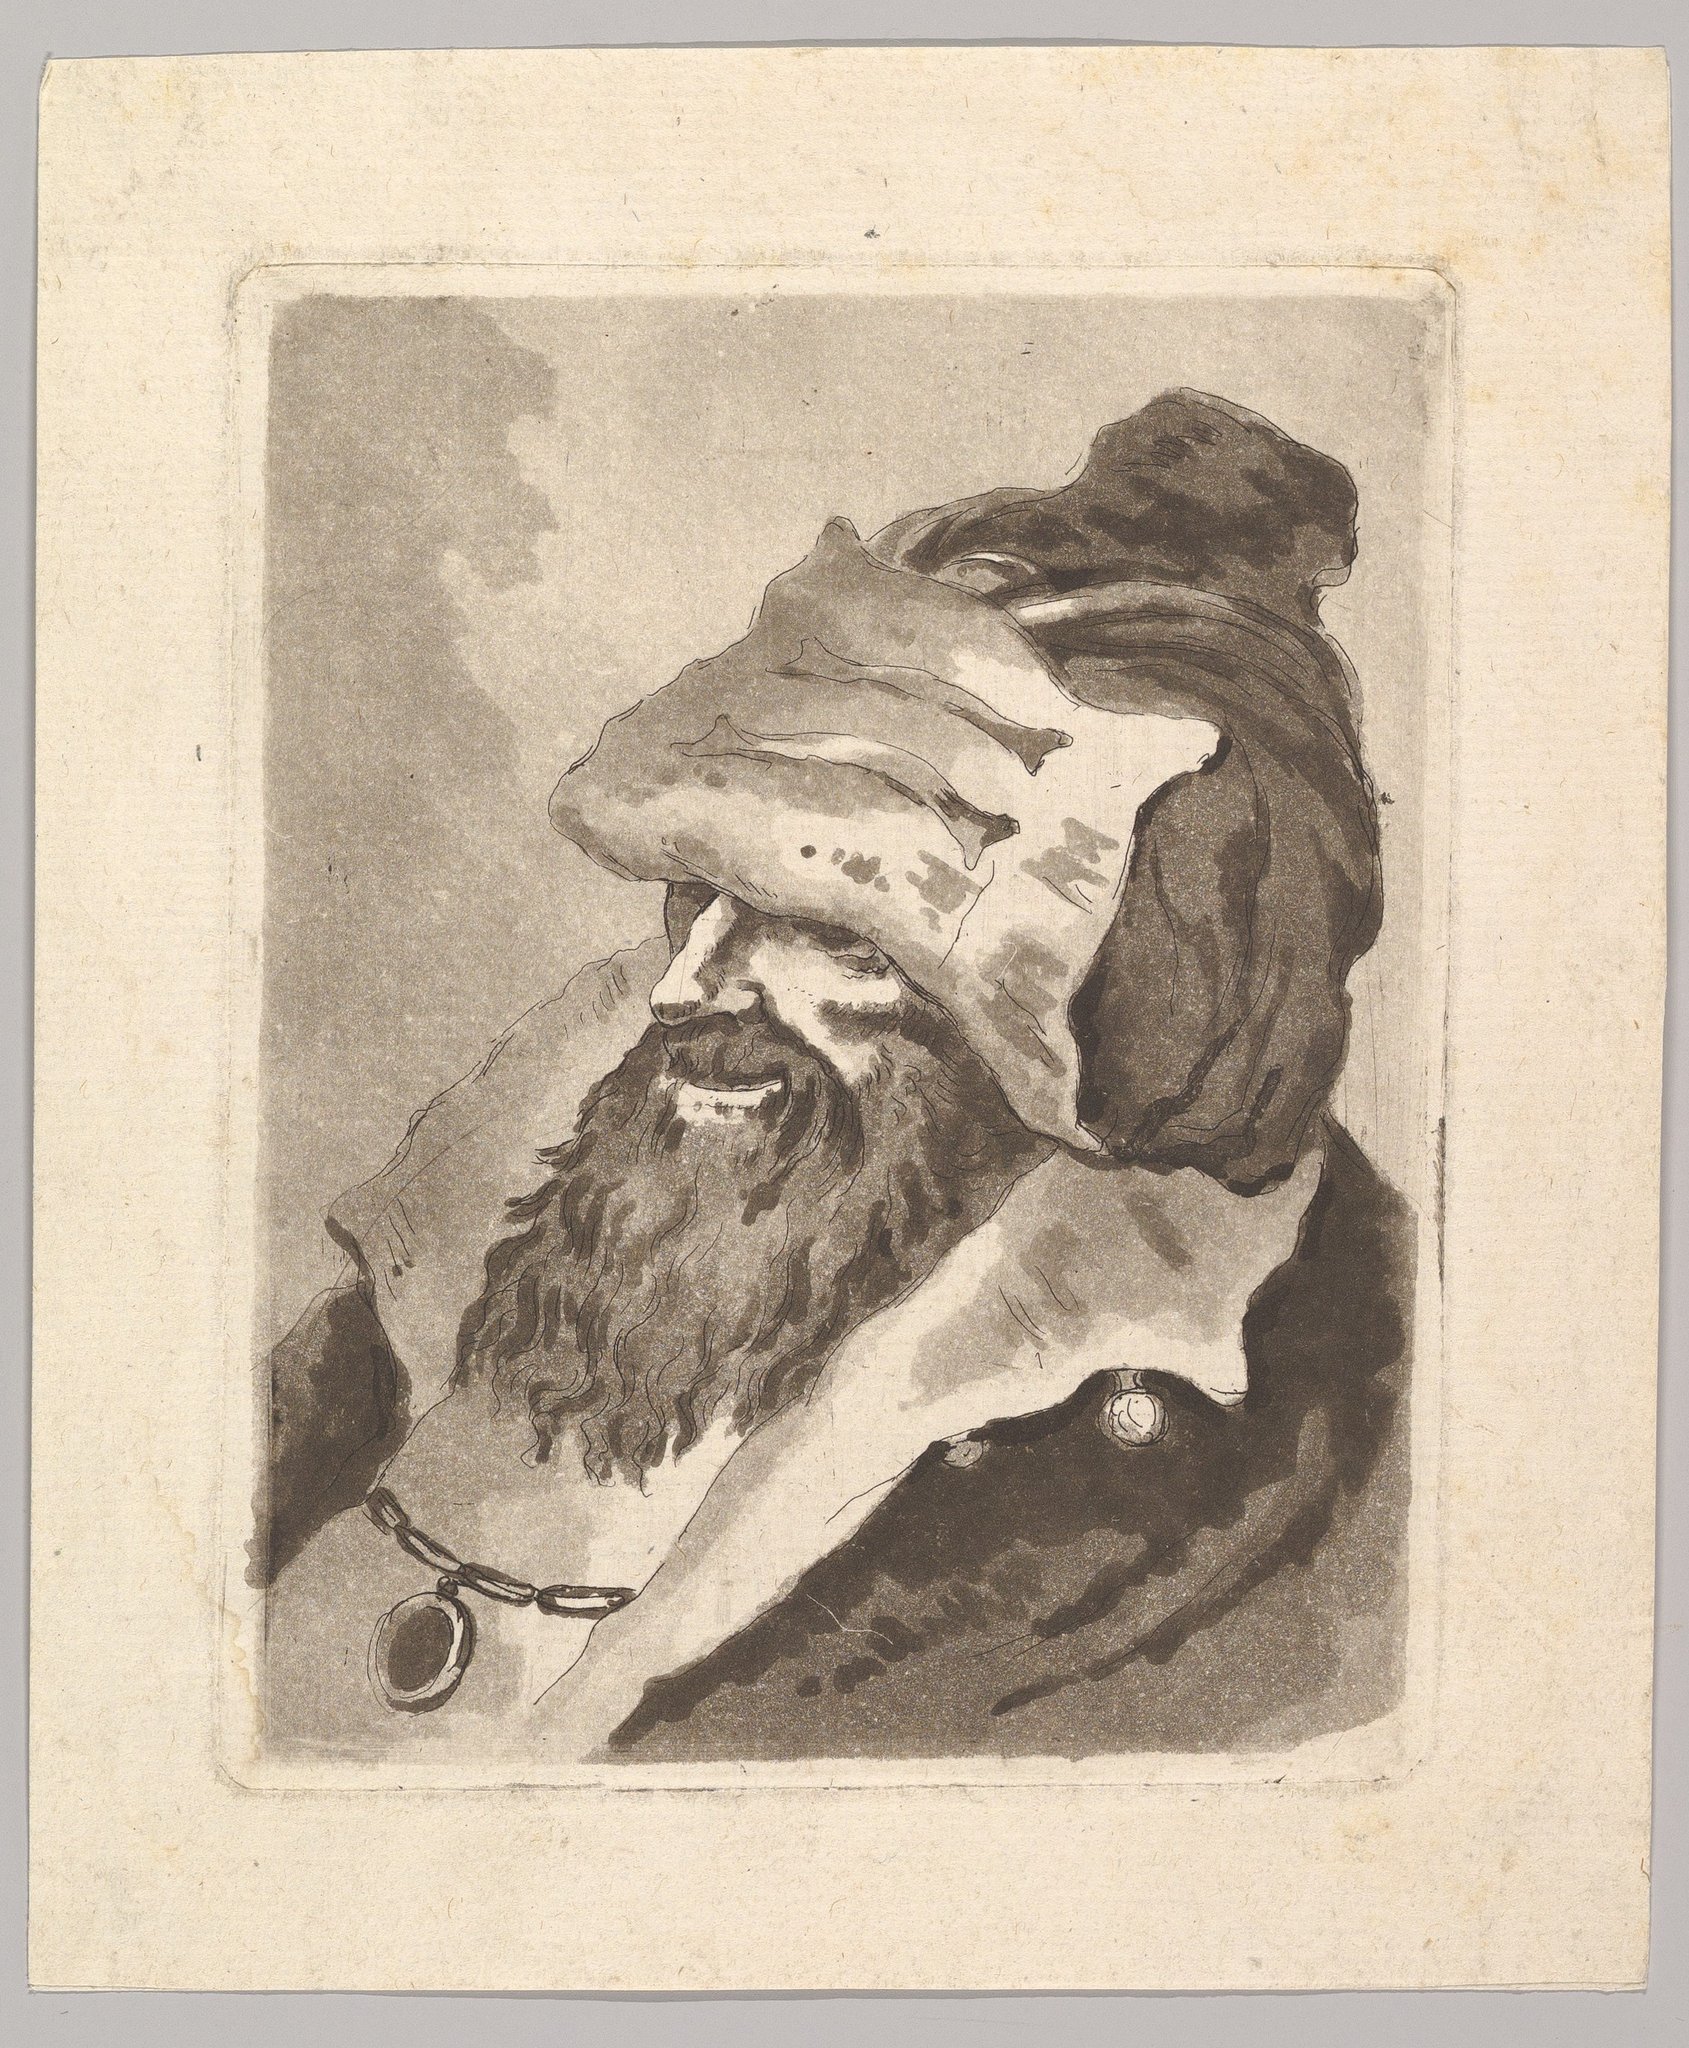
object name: print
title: Fragments choisis dans les Peintures et les Tableaux les plus interessants des Palais et des Eglises d'Italie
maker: jean claude richard, abbé de saint-non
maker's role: artist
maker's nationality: french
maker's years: 1727-1791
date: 1701-1800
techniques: etching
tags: men,portraits